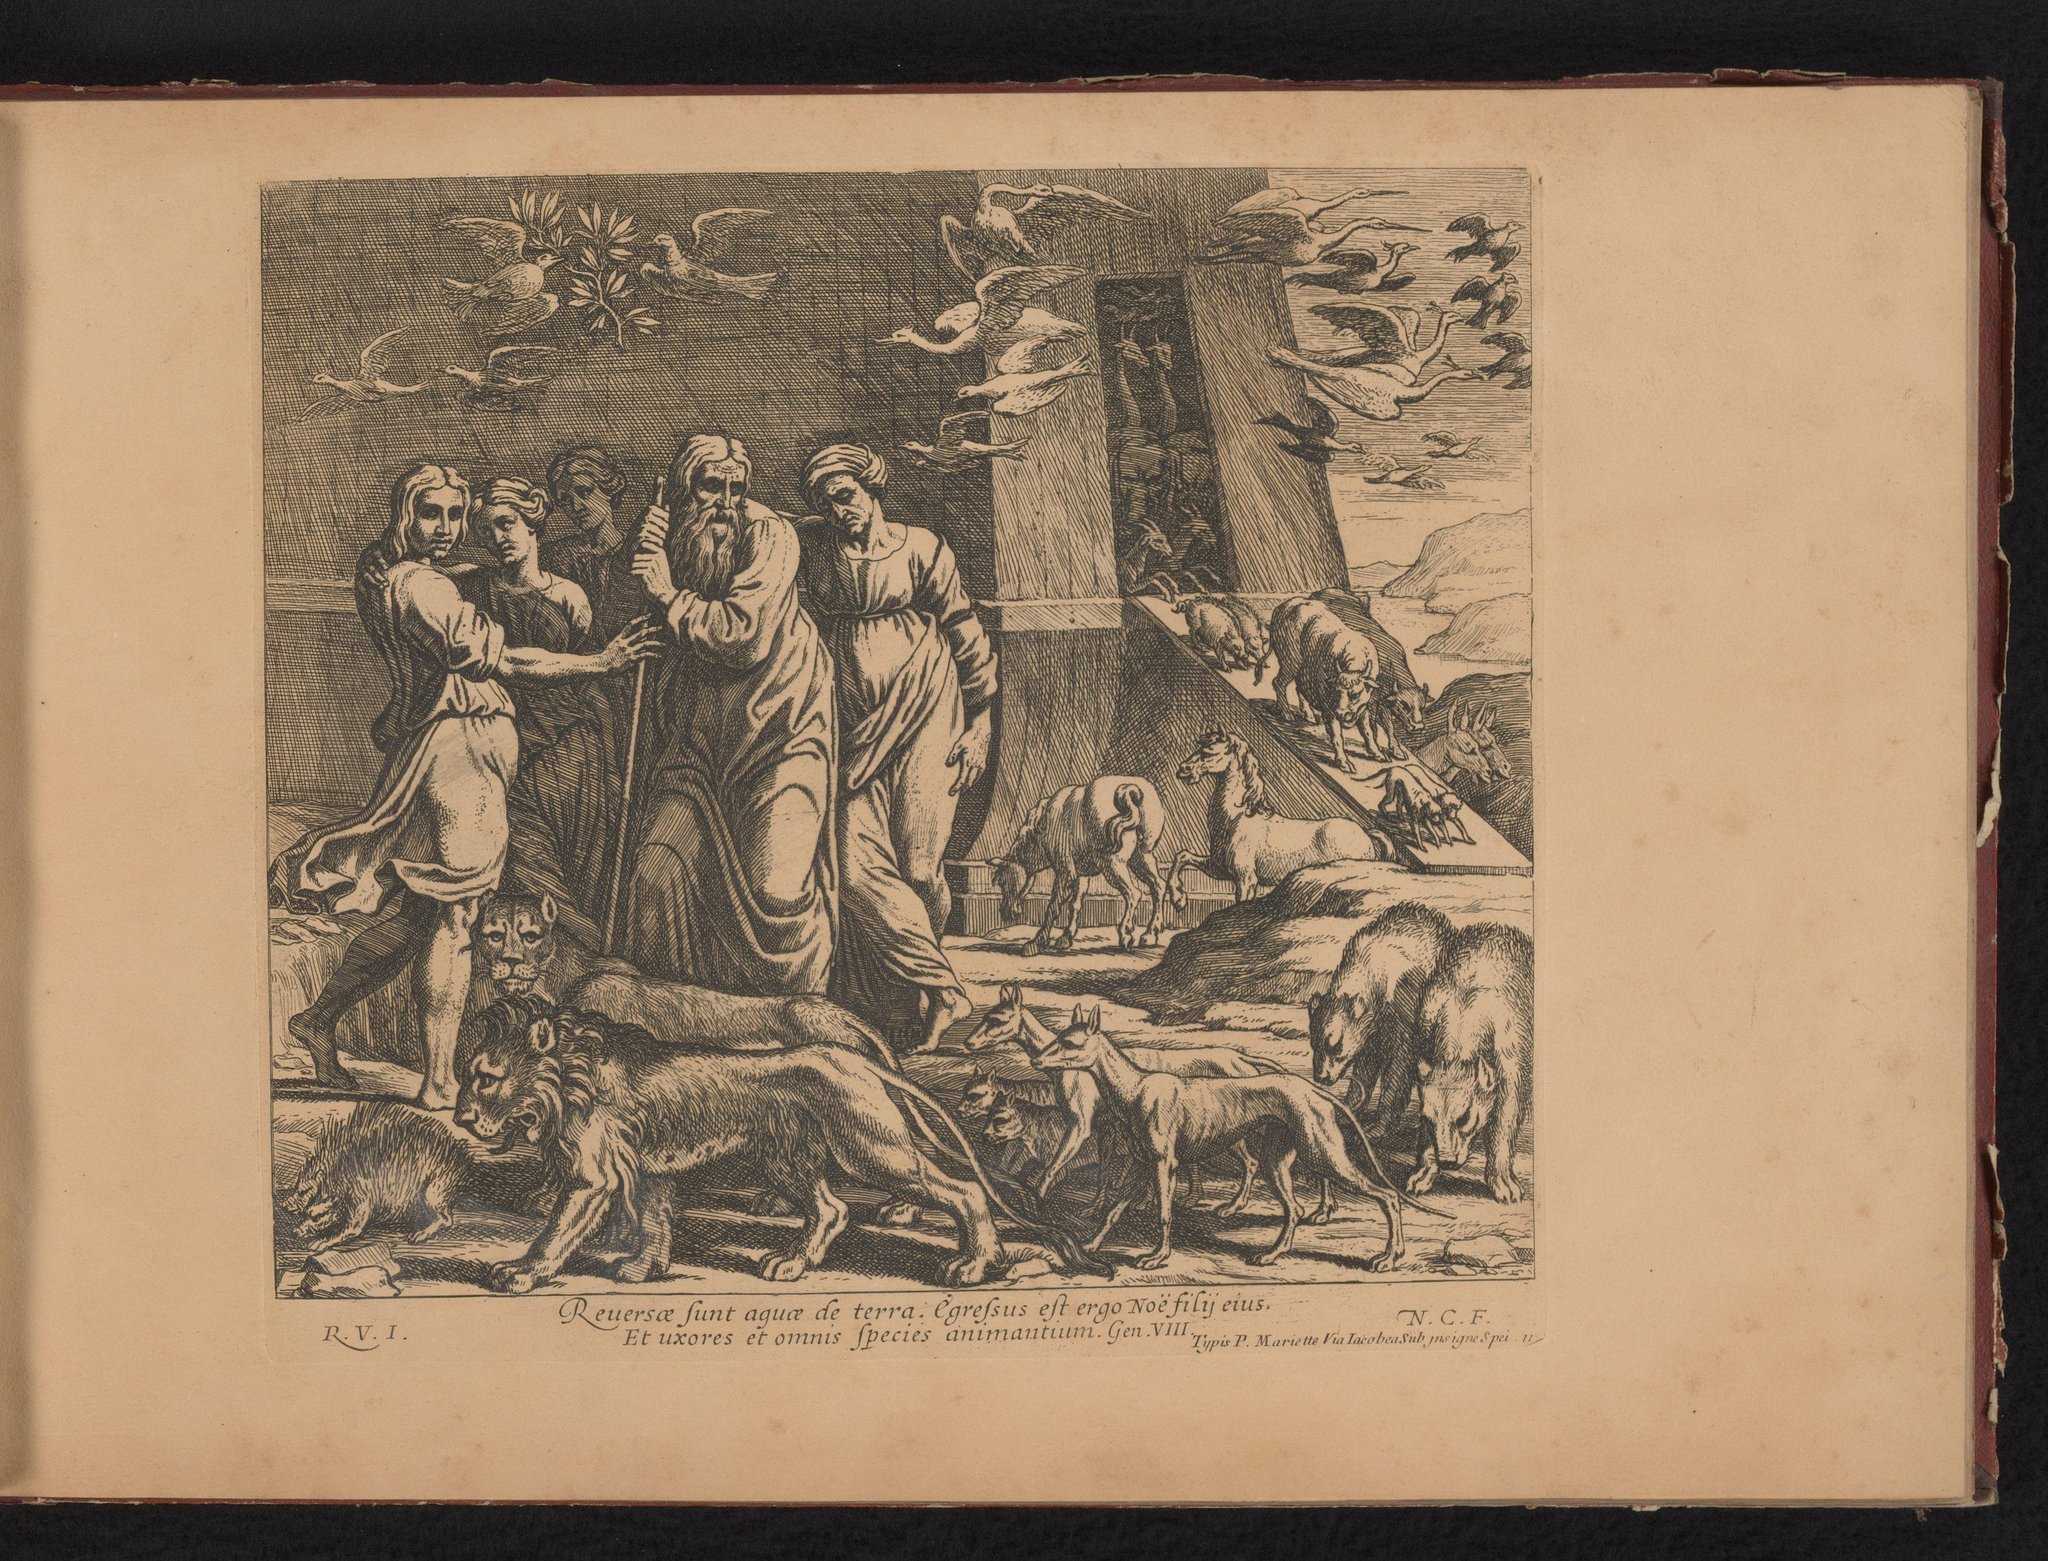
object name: album leaf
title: Sacrae historiae acta a Raphael Urbin in Vaticanis xystis ad picturae miraculum expressa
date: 1649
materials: paper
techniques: etching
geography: paris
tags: the flood and destruction of mankind ~ story of noah (genesis 7:10 - 8:17)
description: Deze prent maakt deel uit van een album.